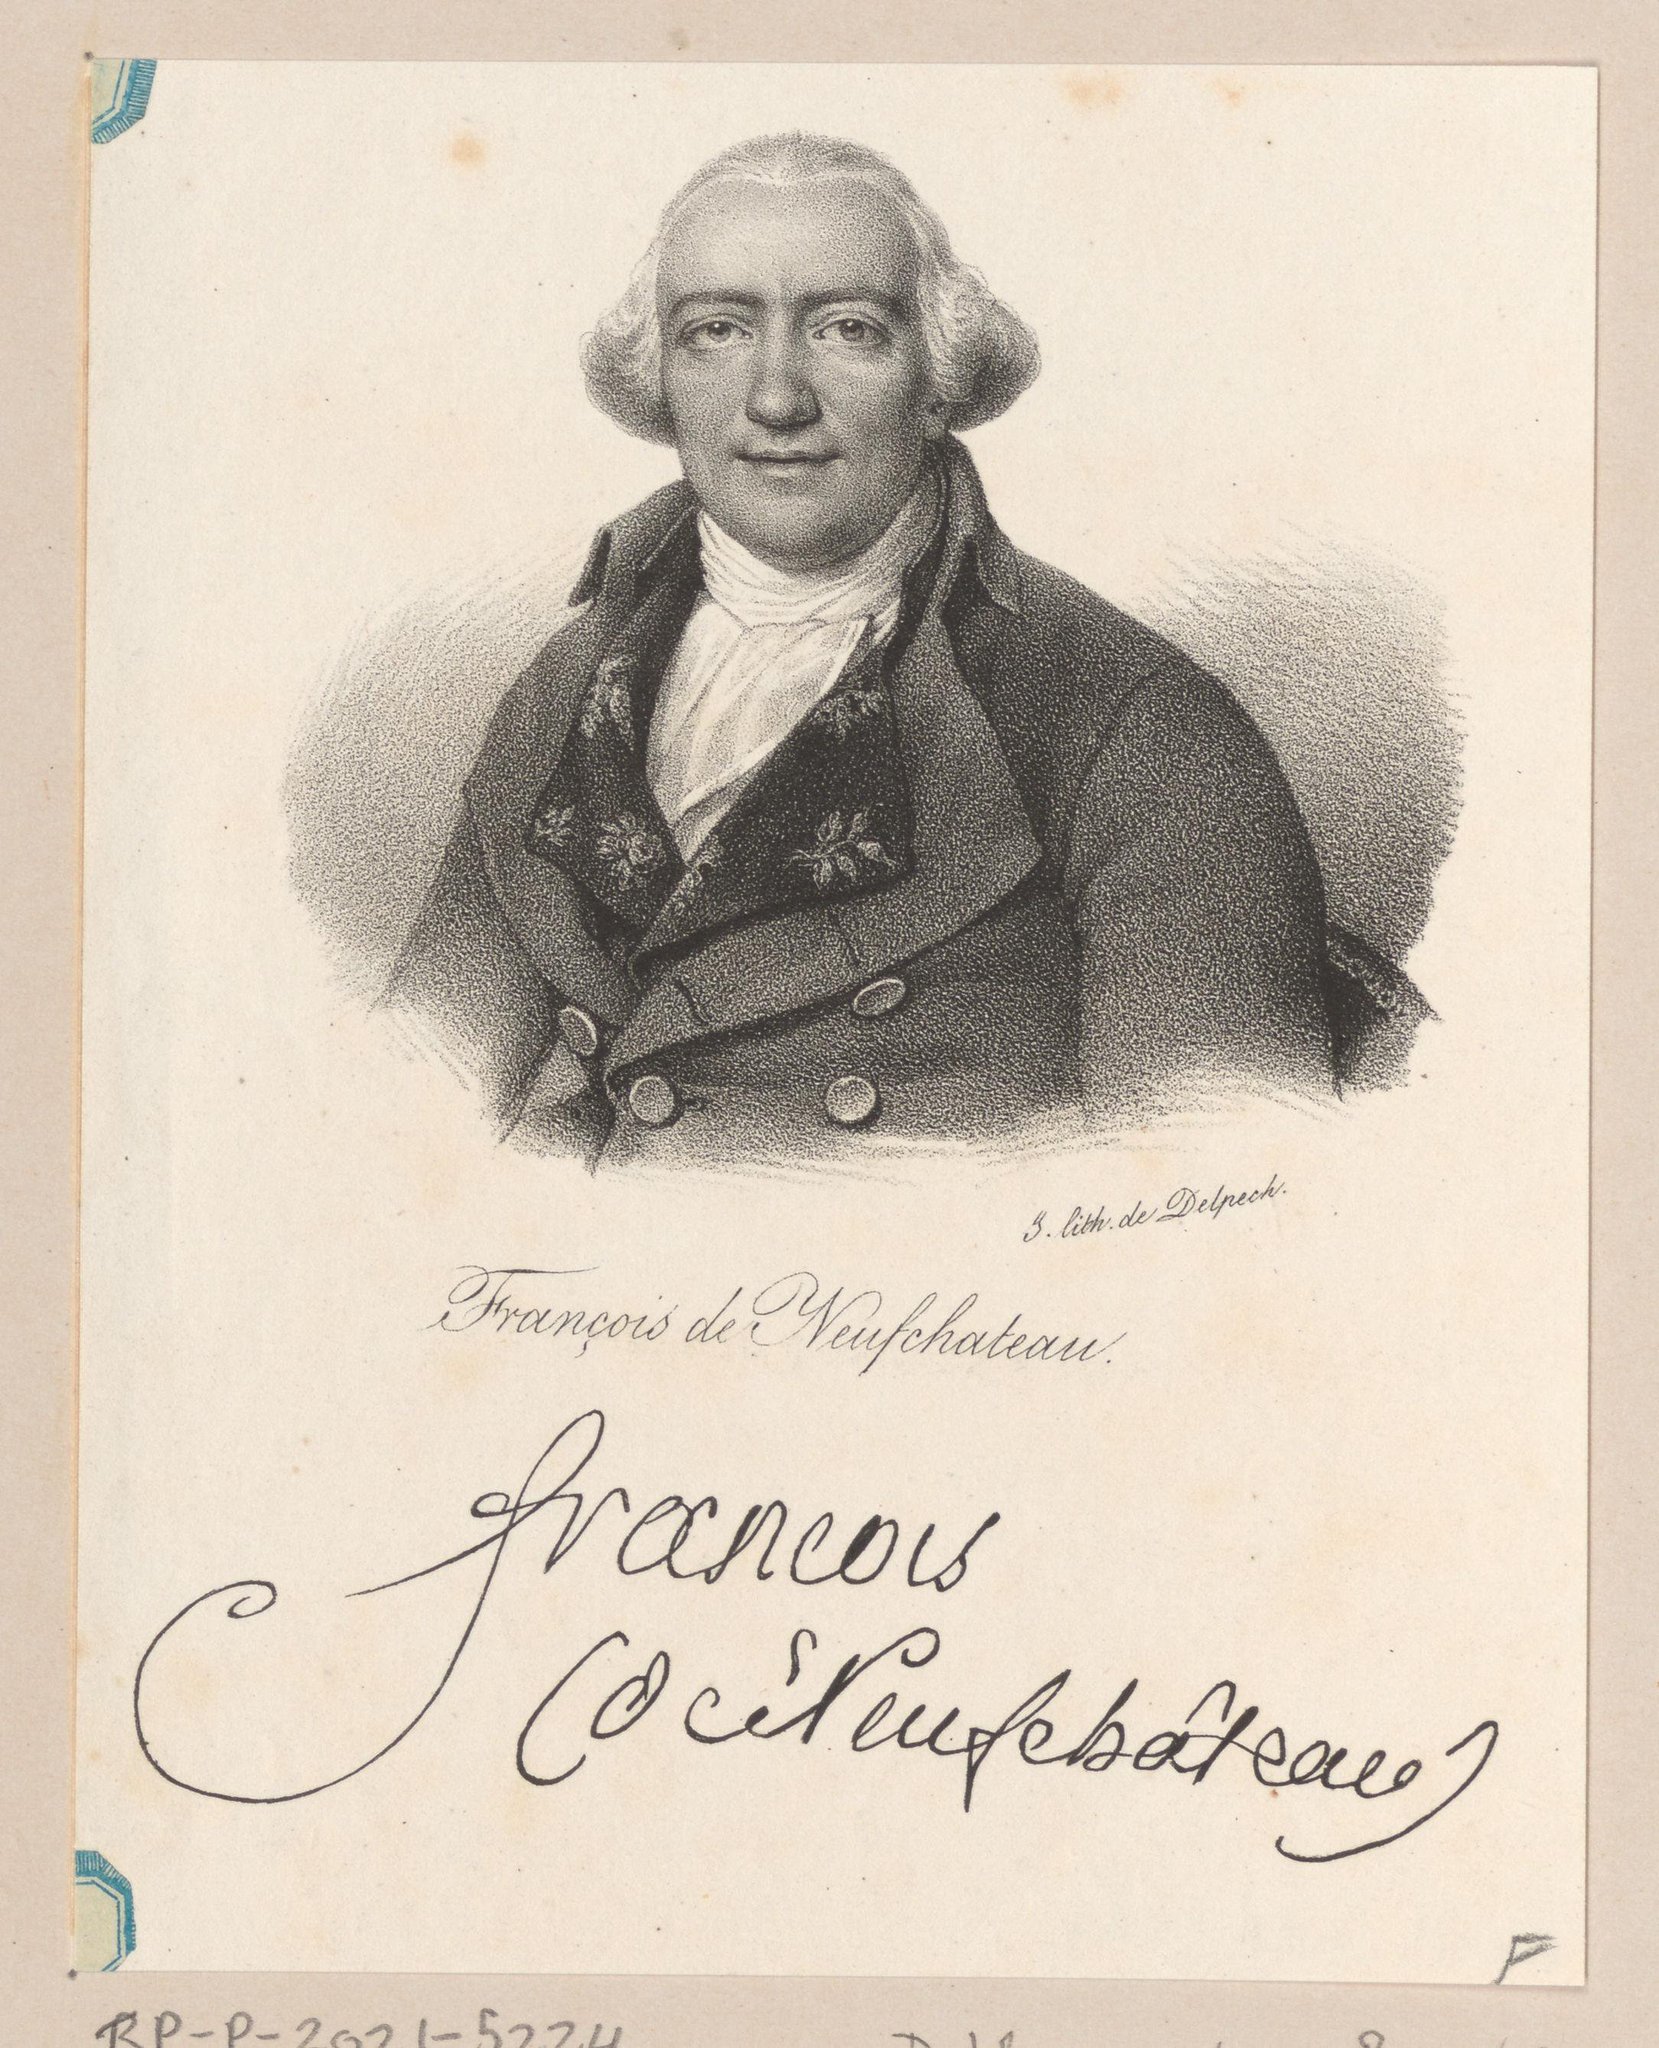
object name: print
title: Portret van Nicolas François, graaf van Neufchâteau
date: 1818-1842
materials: paper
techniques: lithograph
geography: paris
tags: paris, politician, historical persons, politician, e.g. party leader, writer, poet, author